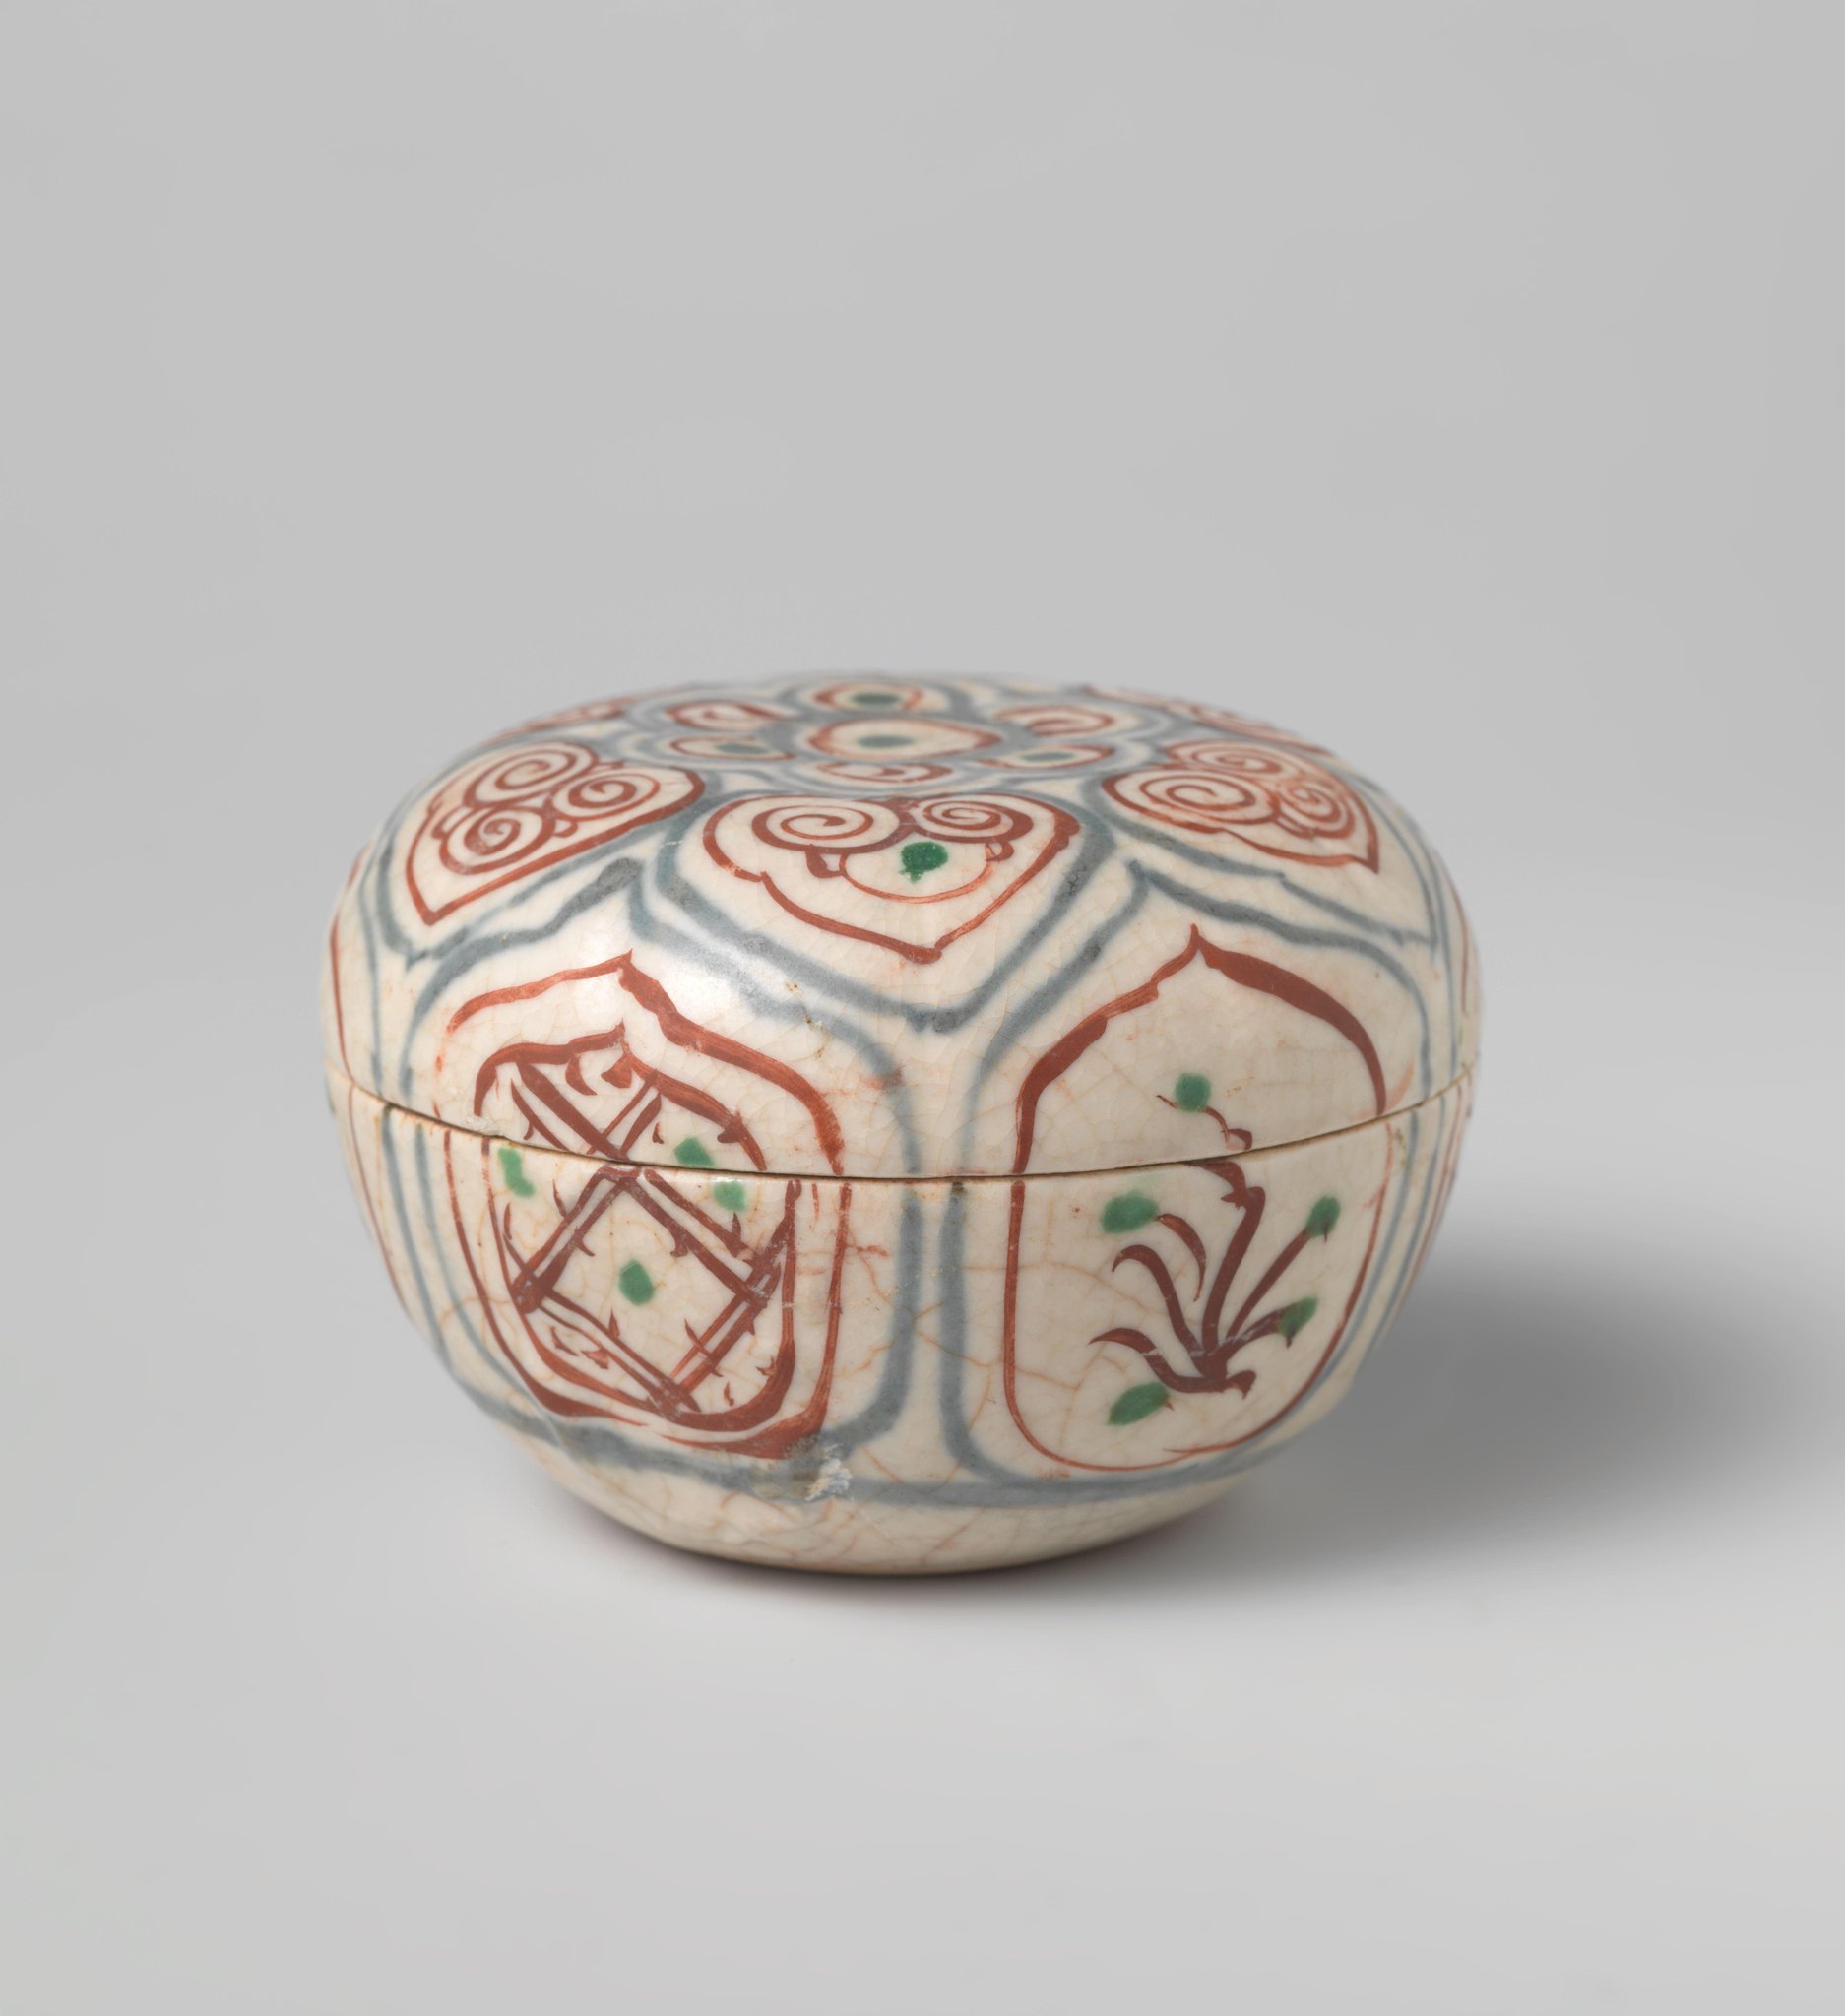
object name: lid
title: Box with diaper pattern and flowering plants in a panel decoration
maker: Anonymous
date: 1400-1600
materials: cobalt, glaze, paint, stoneware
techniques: firing, turning, vitrification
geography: vietnam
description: Deksel van doos van steengoed, beschilderd in onderglazuur blauw en op het glazuur rood en groen. Op de wand van de doos, doorlopend op de deksel, geschulpte cartouches met afwisselend servetwerk of een bloeiende plant. De bovenzijde van de deksel met een bloemrozet omgeven door een band met een soort ruyi-motieven. Decoratie in navolging van het Chinese kraakporselein.